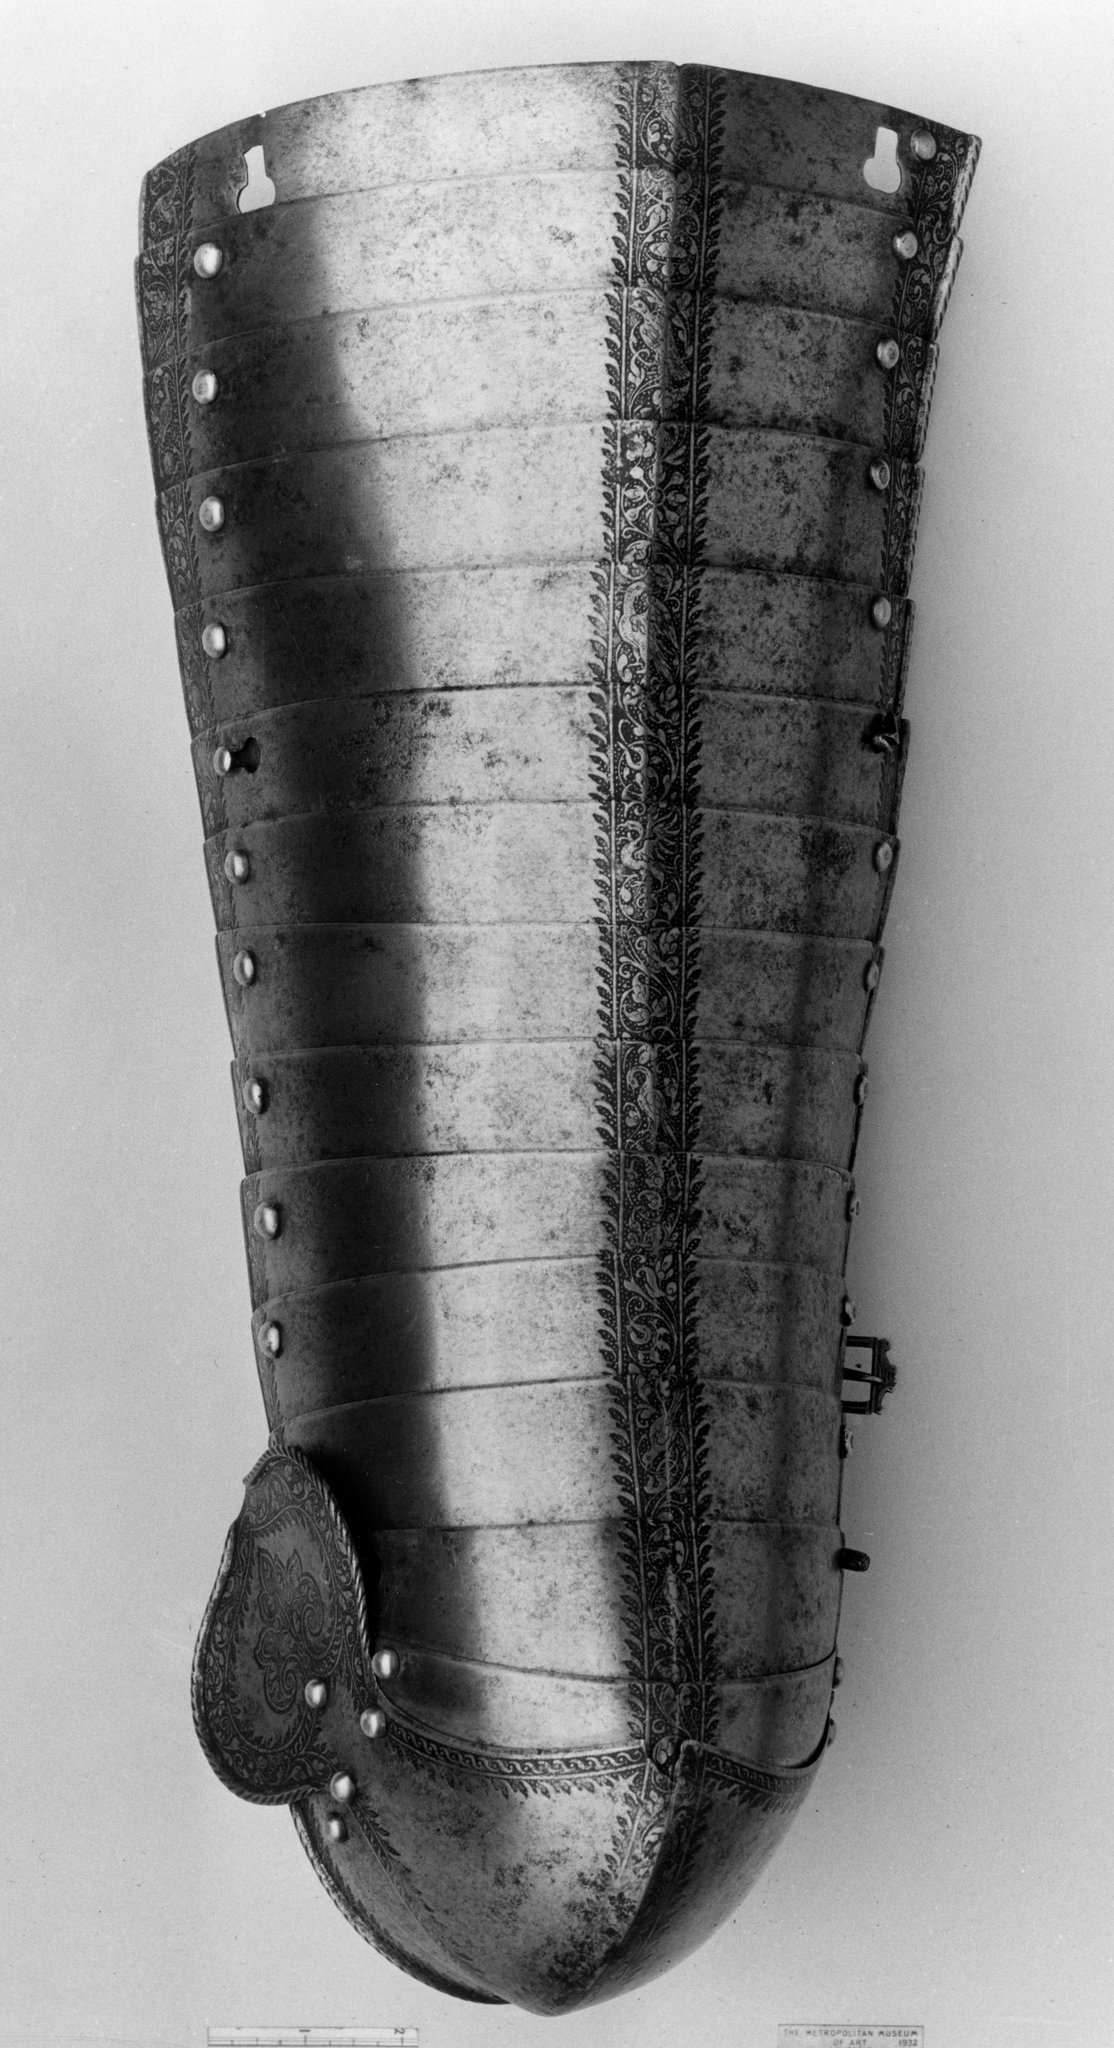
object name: right thigh and knee defense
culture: german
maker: wolfgang grosschedel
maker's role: armorer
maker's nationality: german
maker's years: 1517-1562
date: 1555-1560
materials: steel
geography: germany